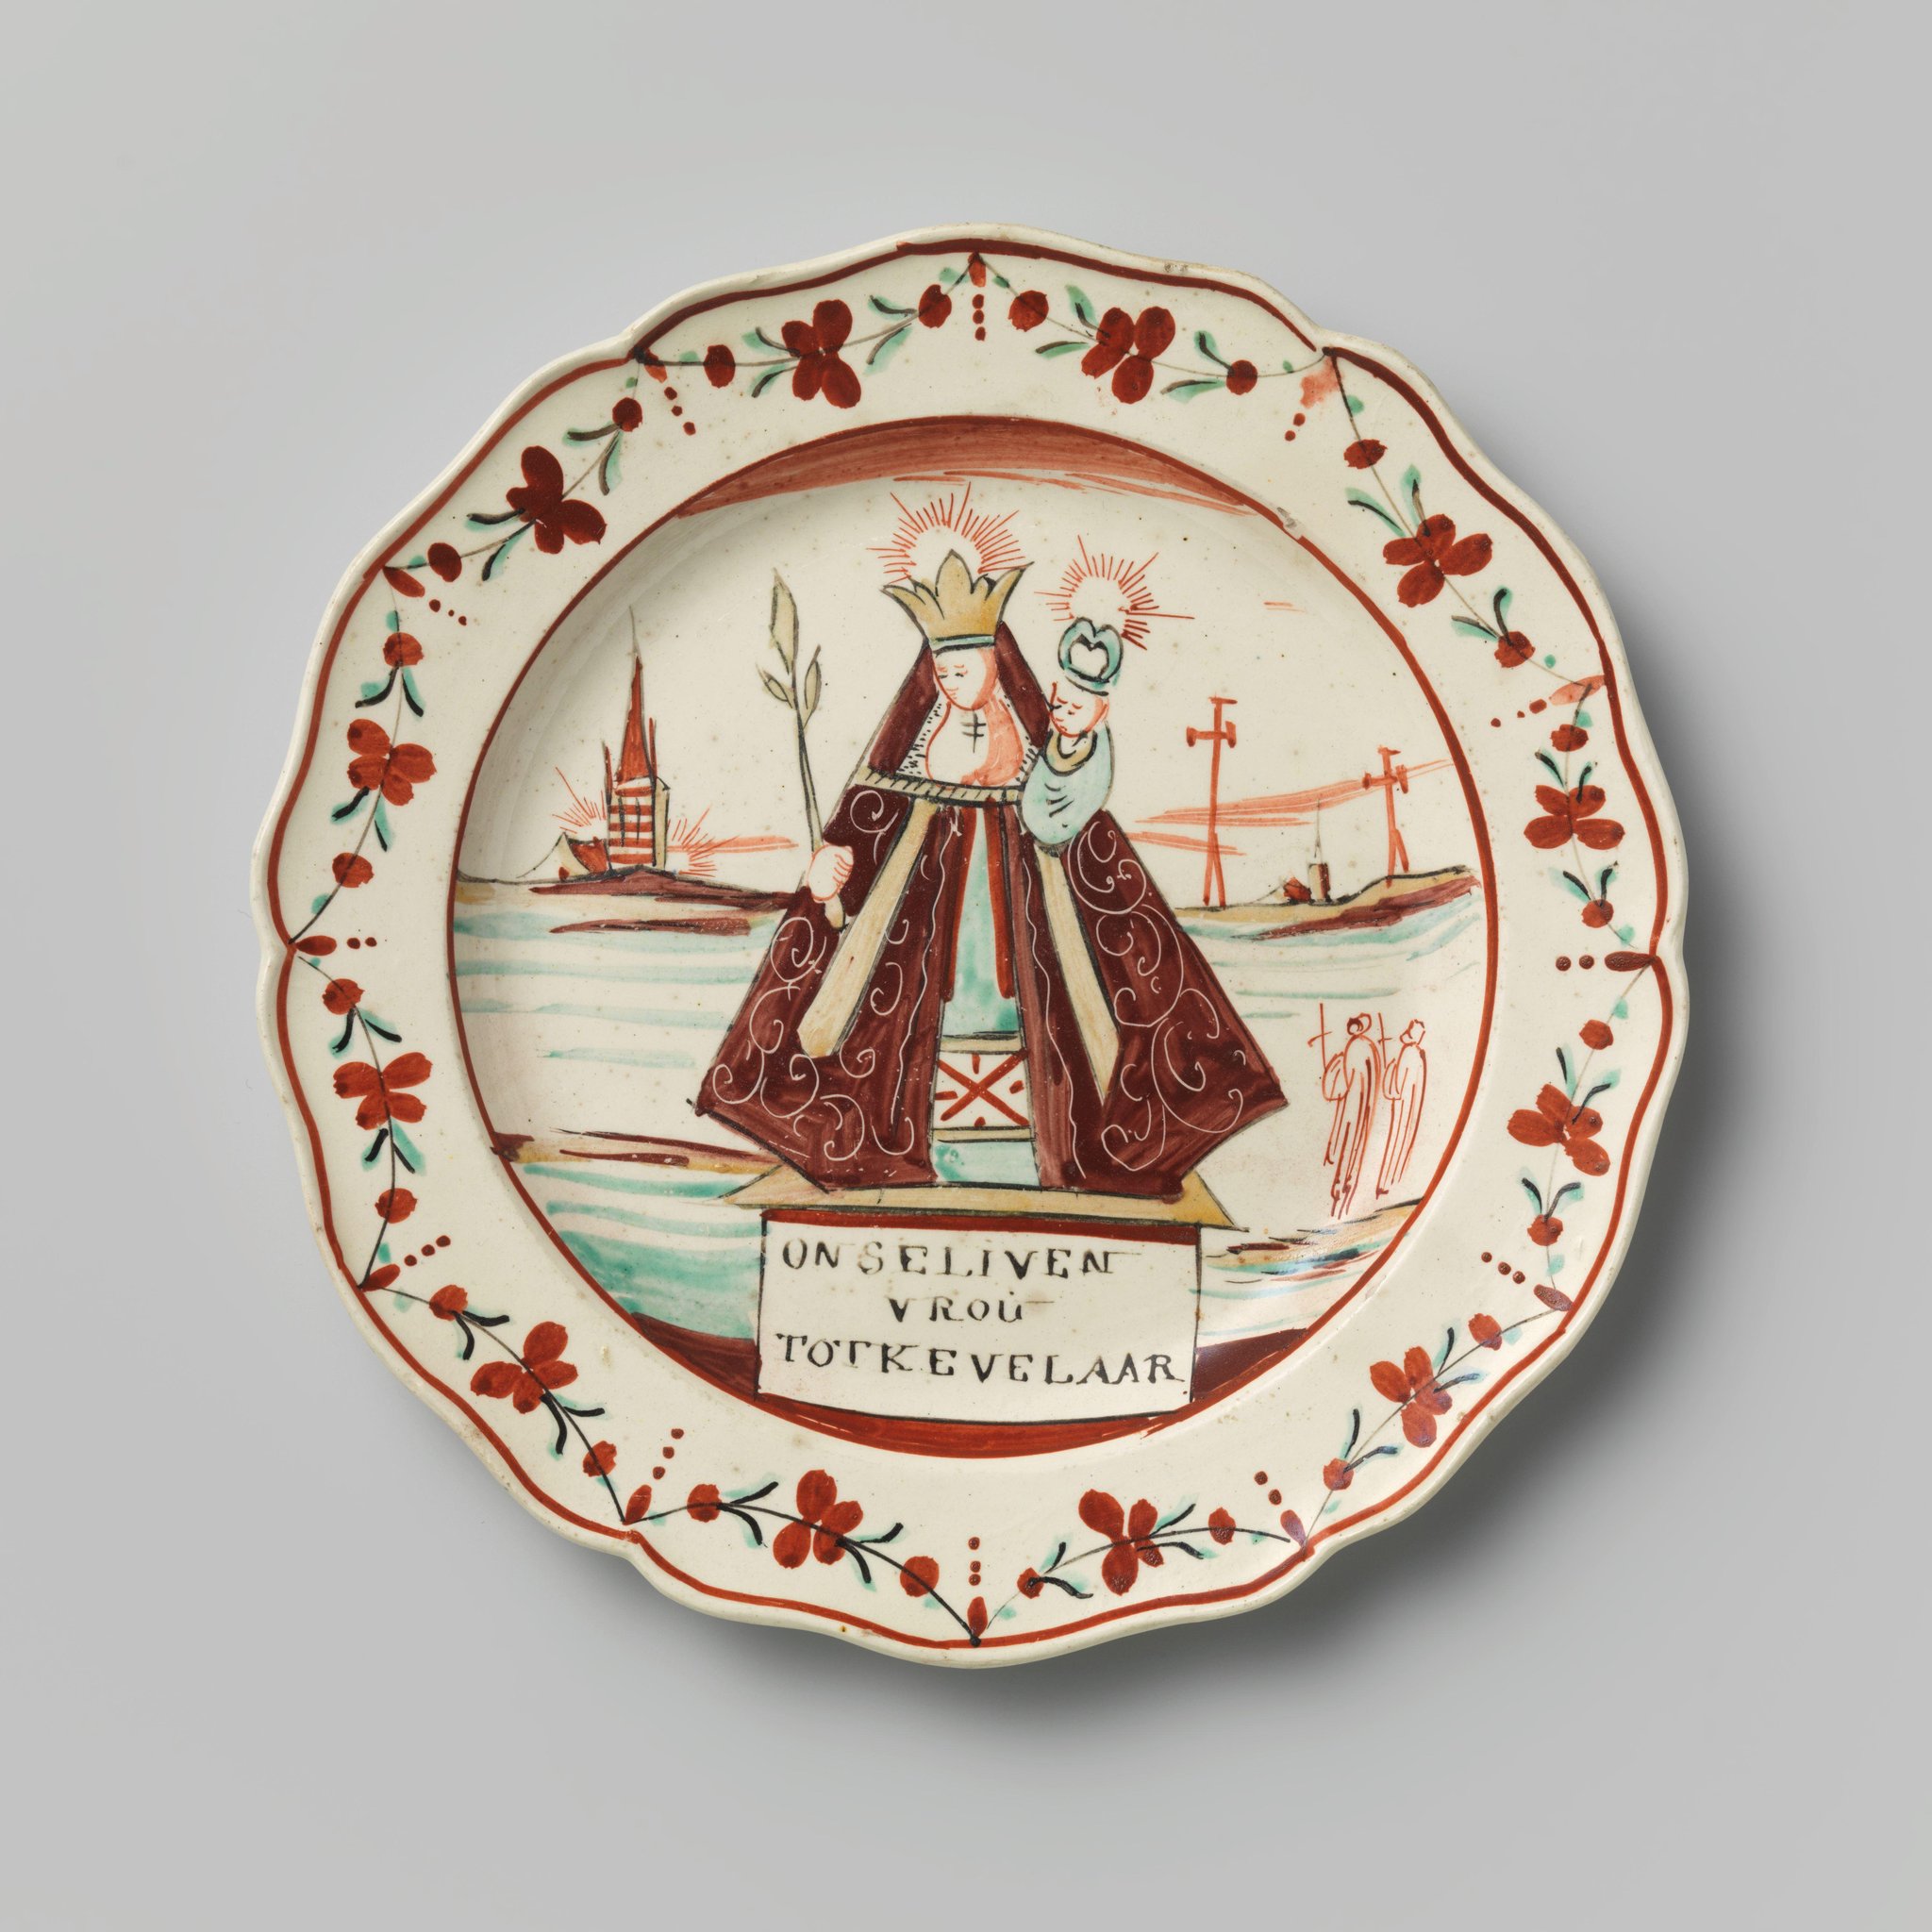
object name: plate dish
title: Rond bord van hardgebakken aardewerk; creamware (Liverpool?)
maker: Anonymous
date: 1780-1800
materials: earthenware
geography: liverpool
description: Rond bord van hardgebakken aardewerk; creamware met decoratie op de glazuur. Op het plat is een vrouw afgebeeld waaronder een rechthoek waarbinnen de tekst: ONSE LIVEN VROU TOT KEVELAAR. De rand is geschulpt en heeft bloemguirlandes als decoratie. Bij het bord hoort een bord met invnr. BK-NM-4221.